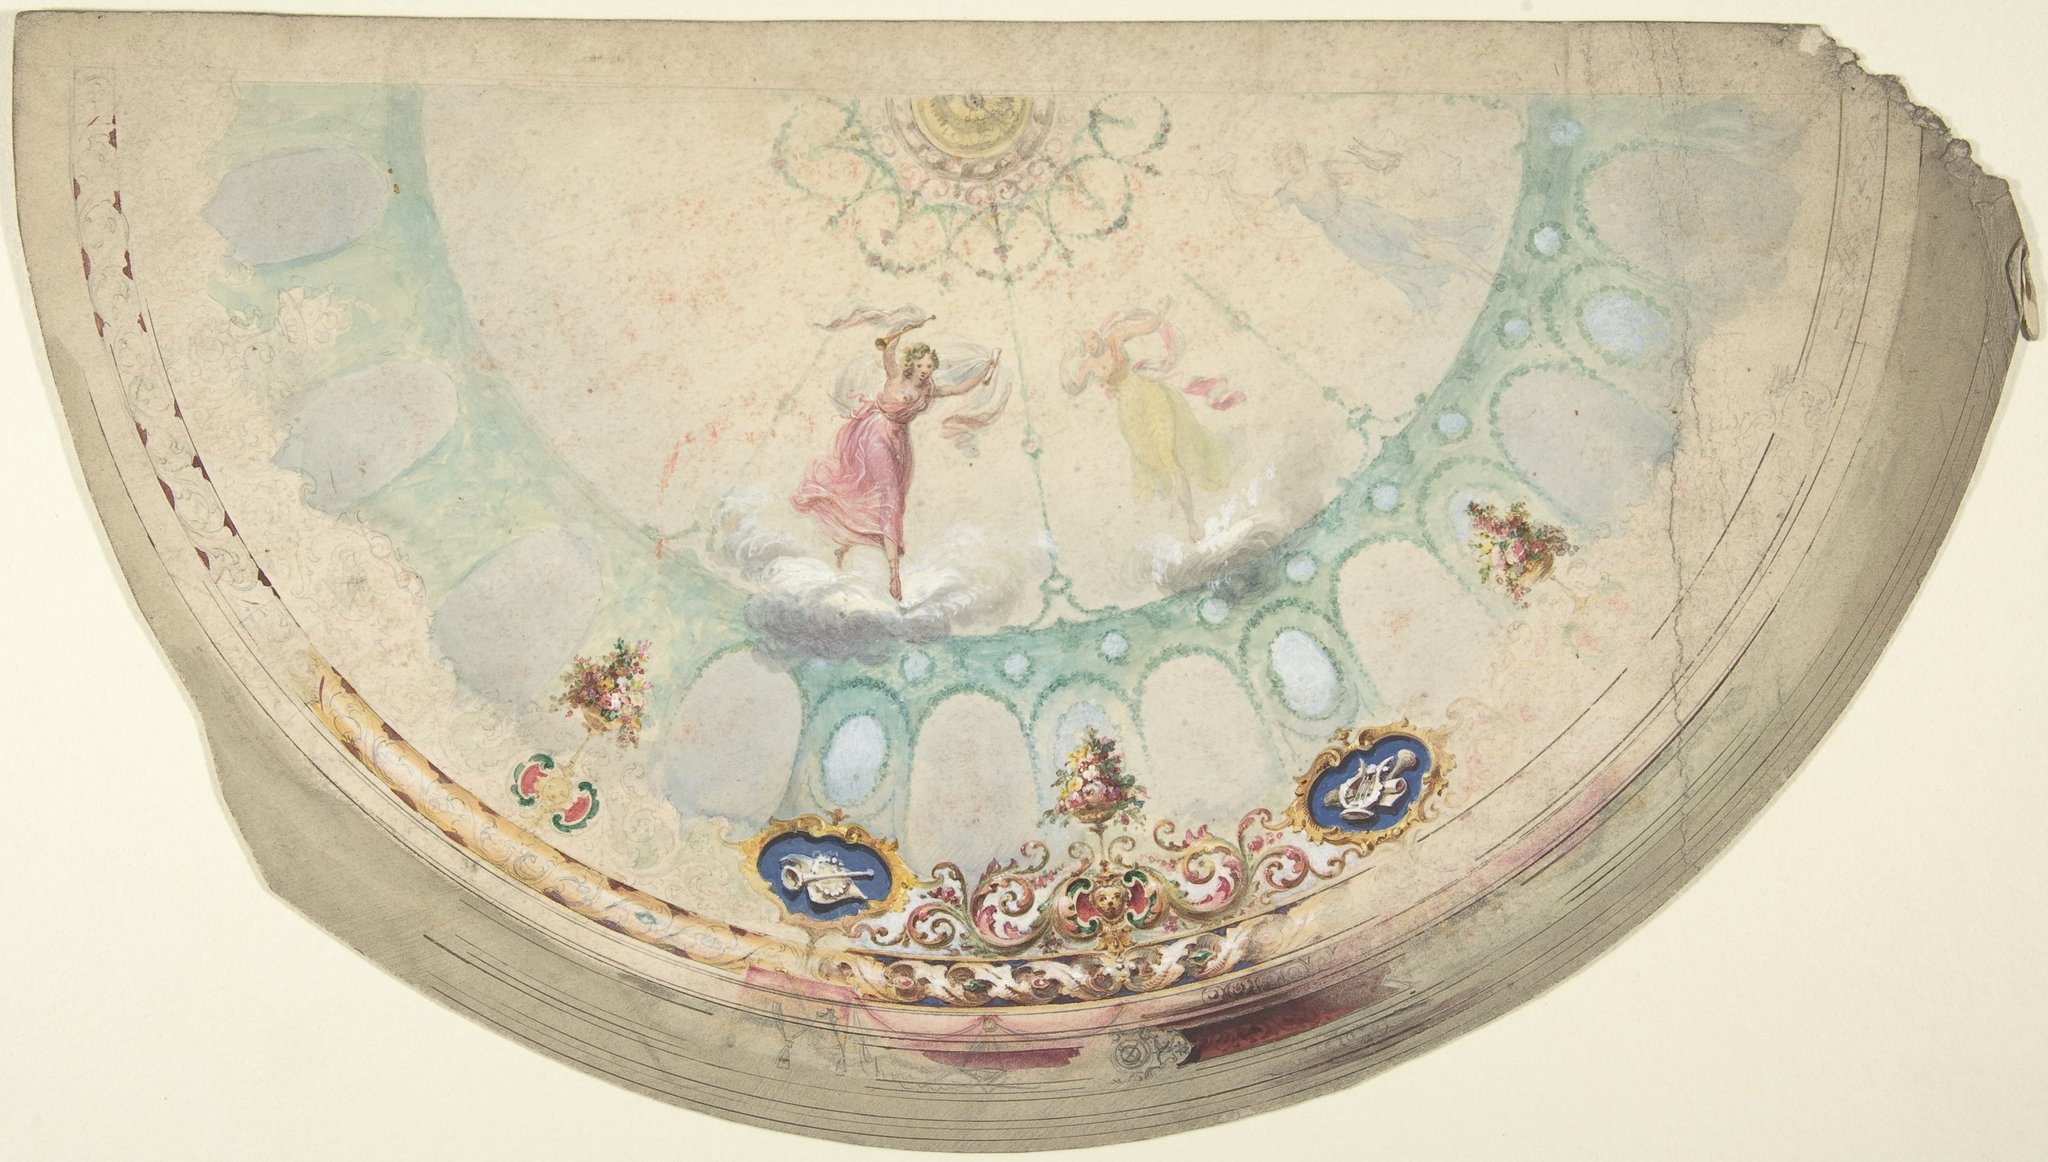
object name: drawing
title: Half of a Circular Ceiling Design with Nymphs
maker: anonymous, british, 19th century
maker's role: artist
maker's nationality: british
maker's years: 1800-1900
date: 1801-1900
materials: ink, watercolor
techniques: pen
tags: nymphs